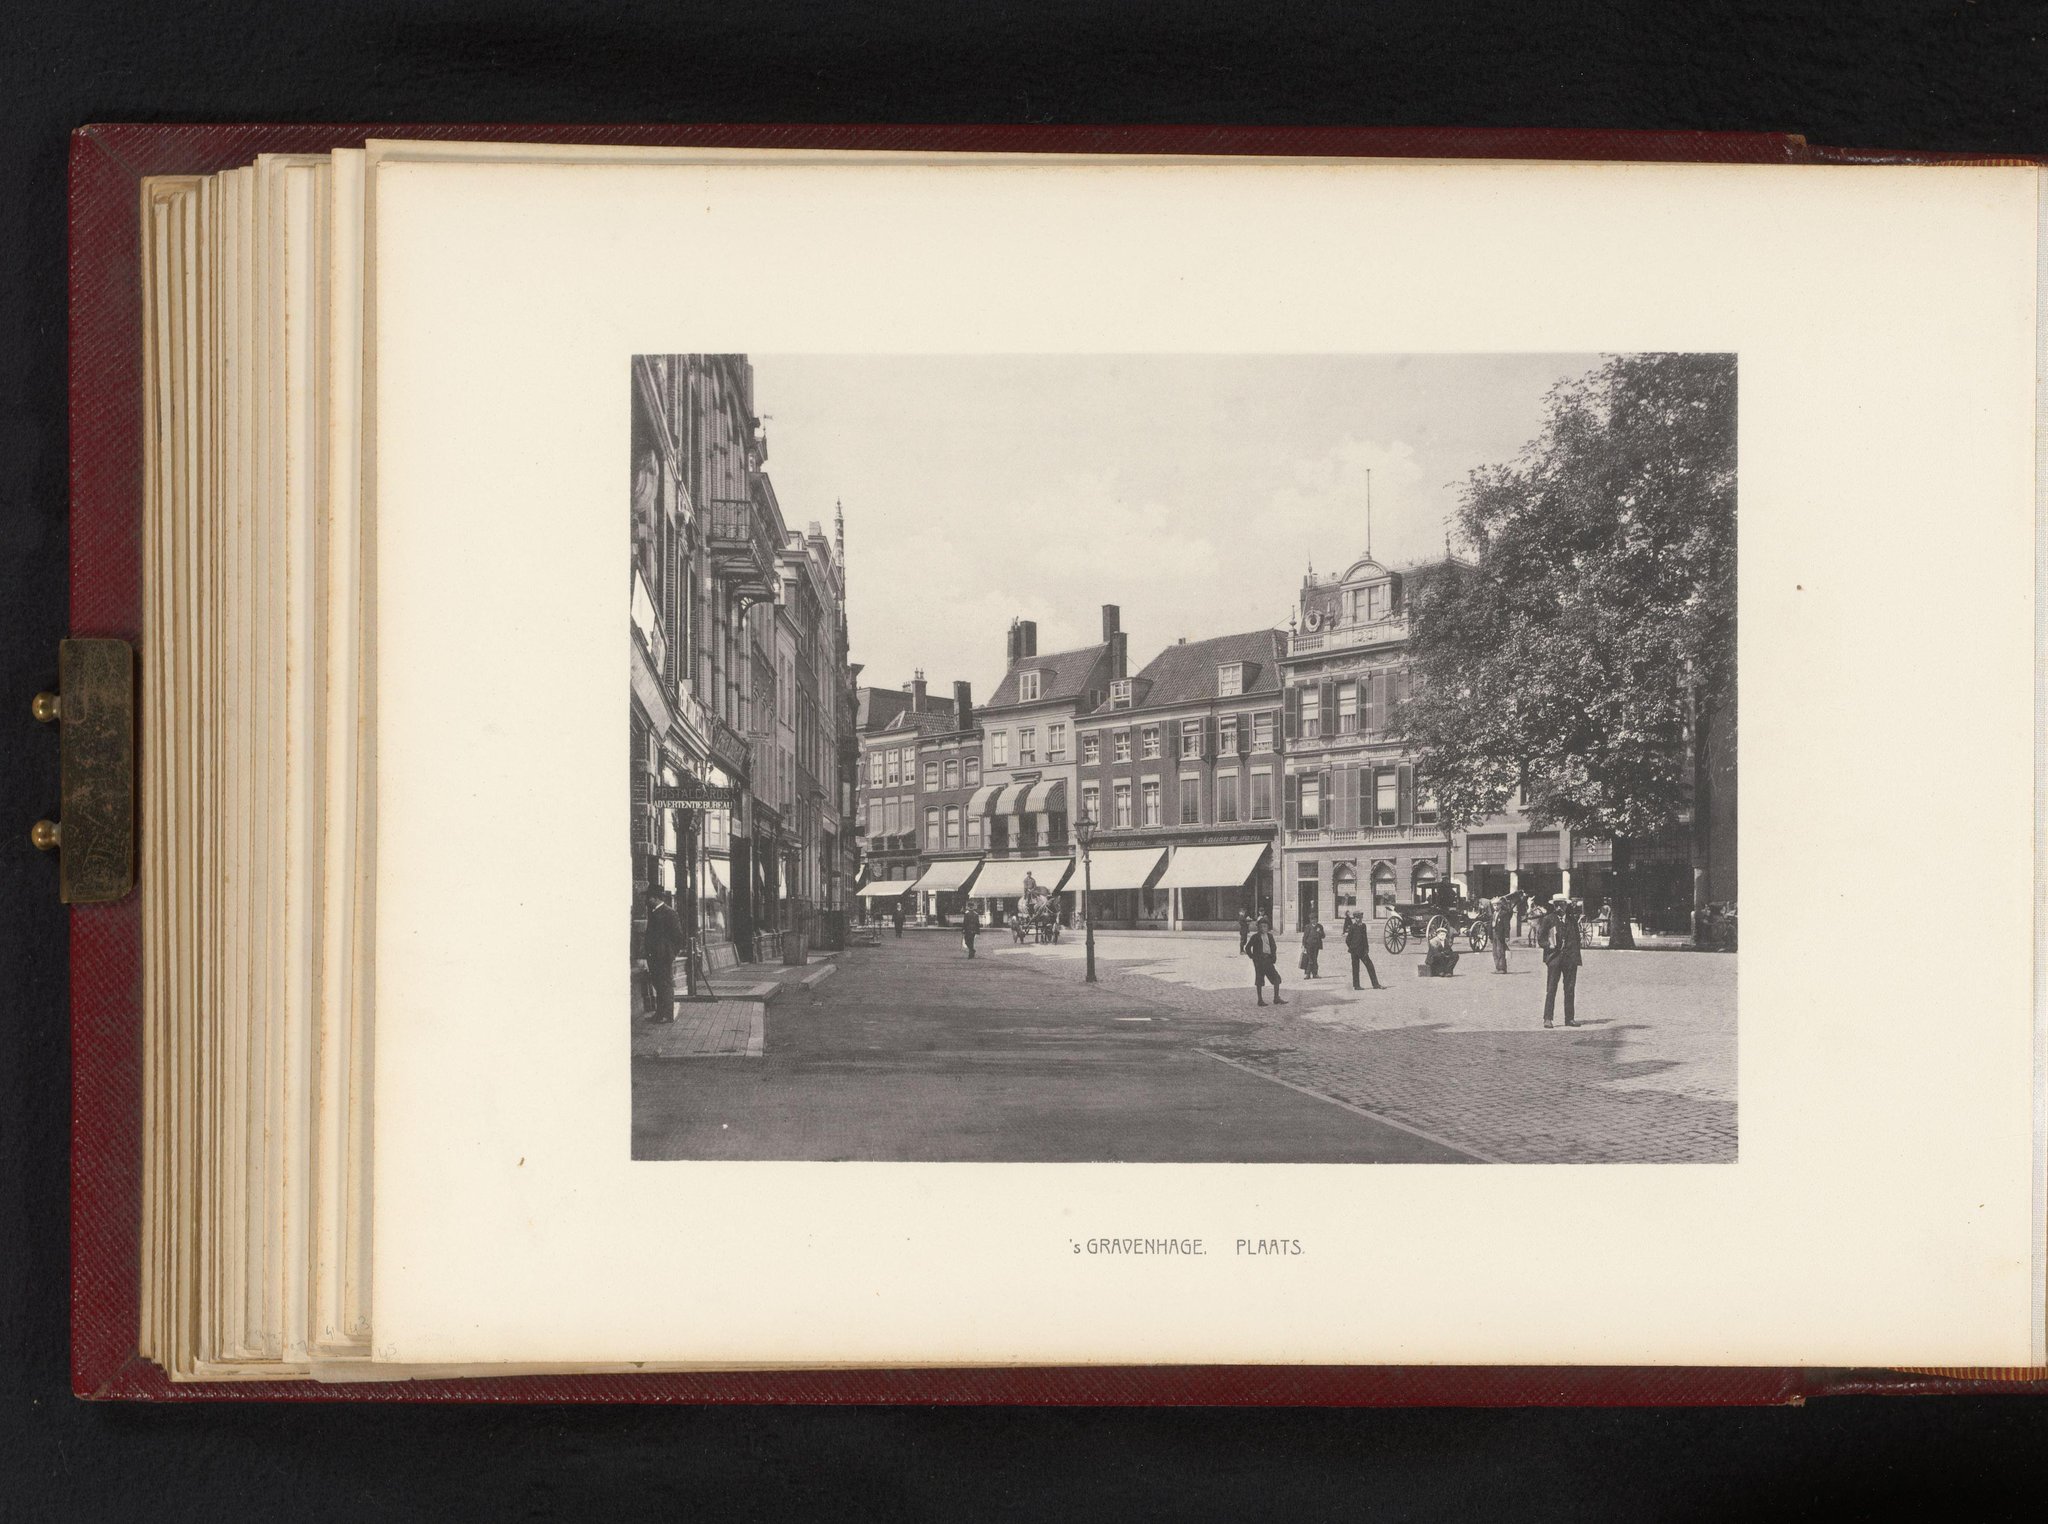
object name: album leaf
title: Gezicht op Plaats te Den Haag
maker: Anonymous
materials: paper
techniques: photograph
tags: square, place, circus, etc. - ii - ideal city, historical persons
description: Deze pagina maakt deel uit van een album.